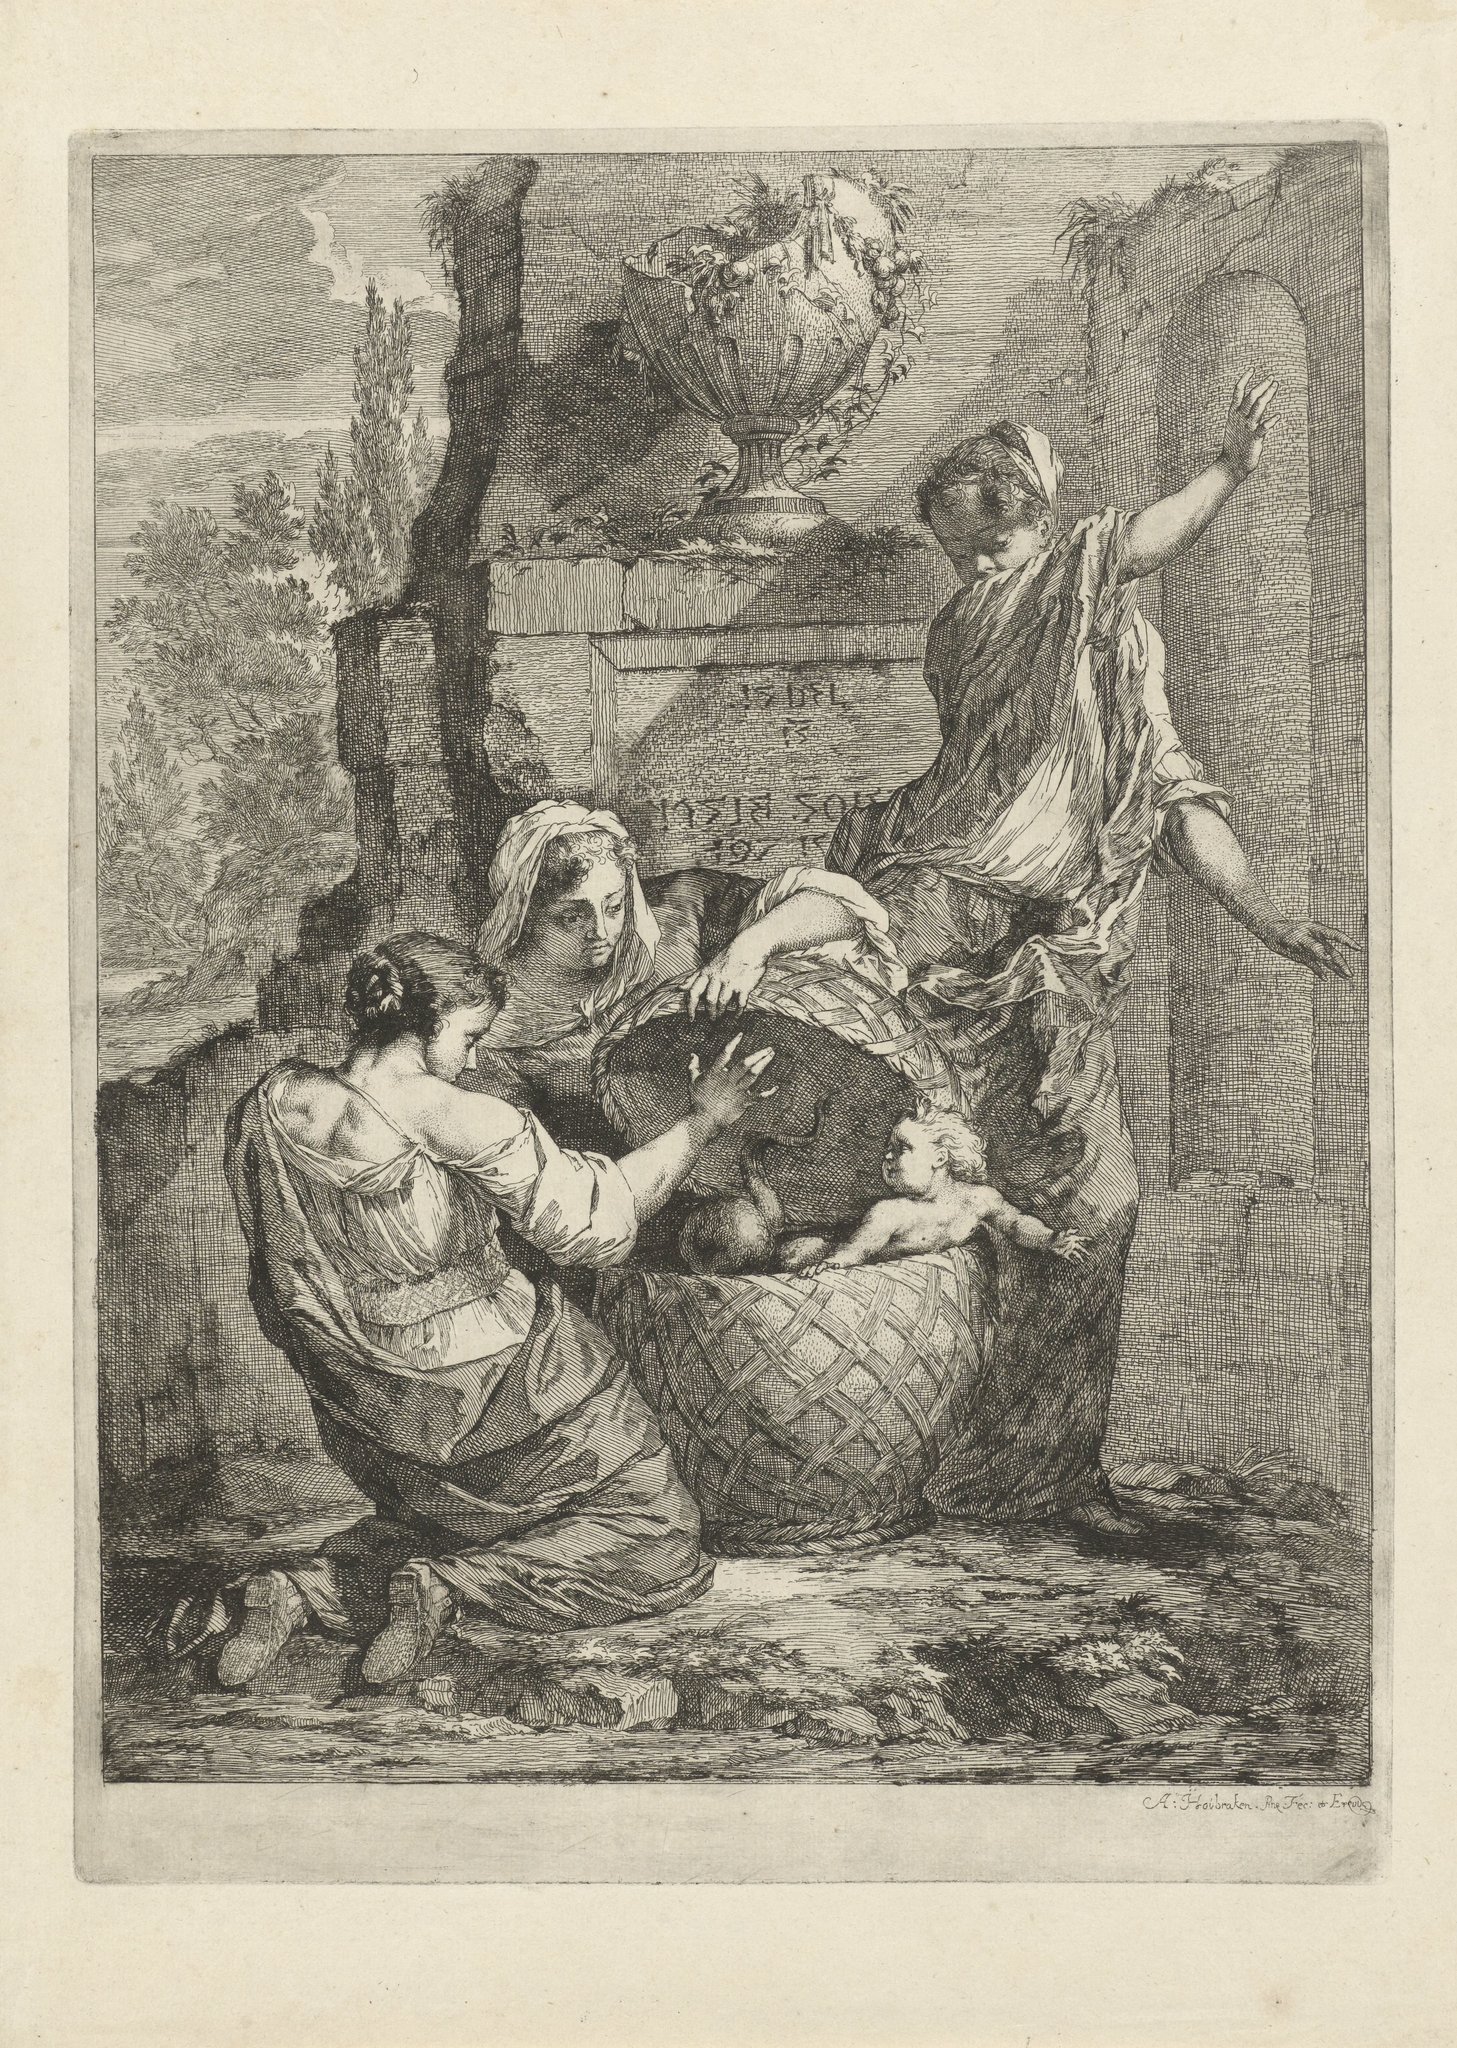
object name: print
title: Erichthonius gevonden door de drie dochters van Cecrops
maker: arnold houbraken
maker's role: draughtsman, painter, print maker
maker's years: 1660-1719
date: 1670-1719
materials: paper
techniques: etching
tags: early life, prime youth of erichthonius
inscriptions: collector's mark: Lugt 240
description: Erichthonius, geboren uit het verspilde zaad van Vulcanus op Moeder Aarde en door Minerva opgesloten in een mand, wordt gevonden door de drie dochters van Cecrops, de koning van Attica. Het kind heeft een slangenstaart in plaats van benen, waar de drie dochter hevig van schrikken.